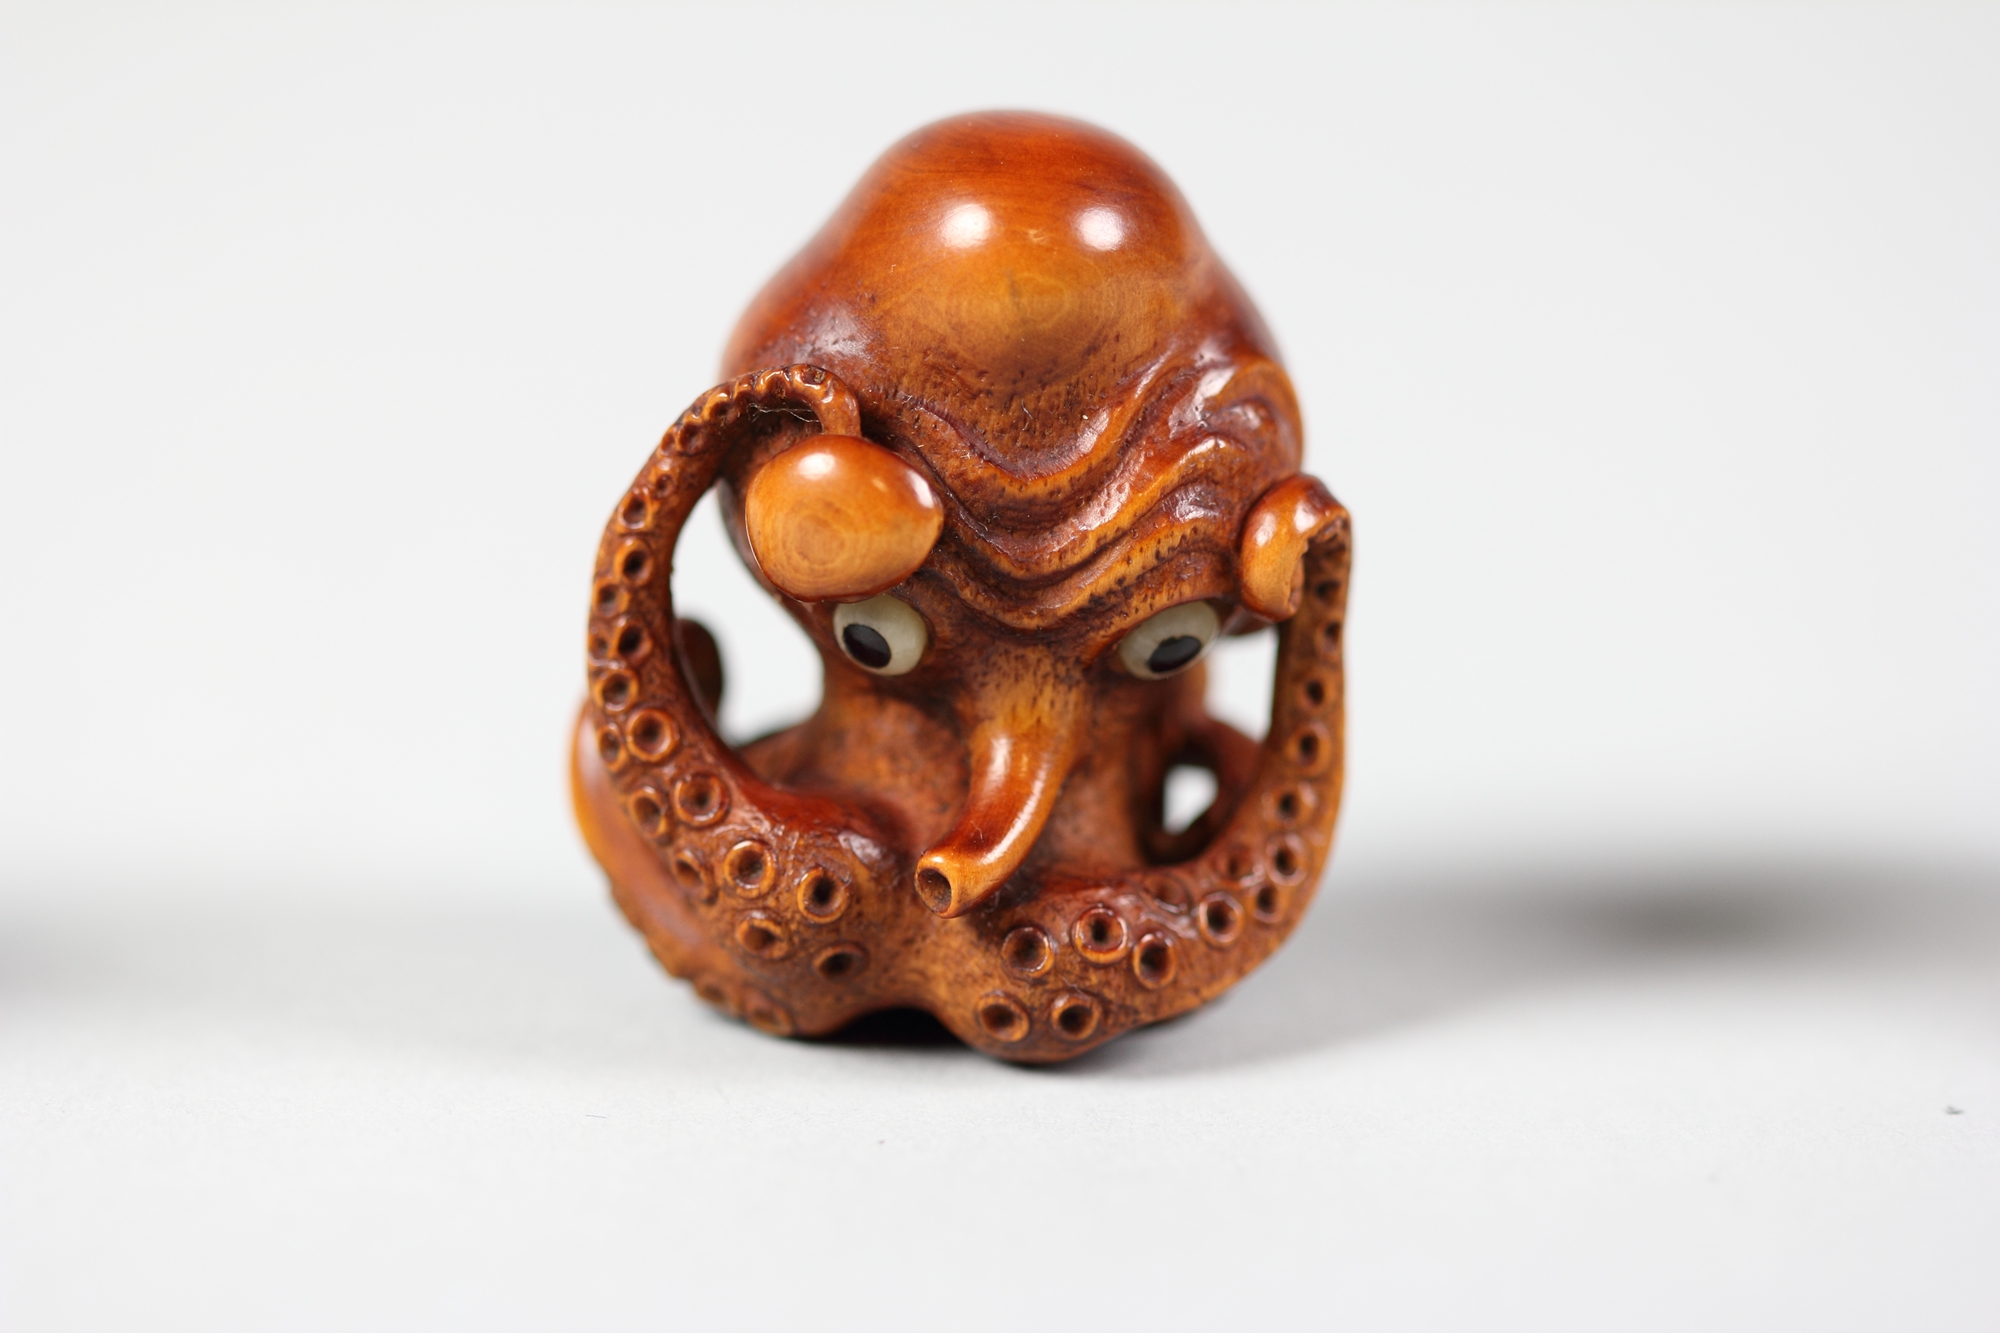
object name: netsuke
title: Netsuke of Octopus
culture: japanese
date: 1801-1900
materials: wood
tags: octopus